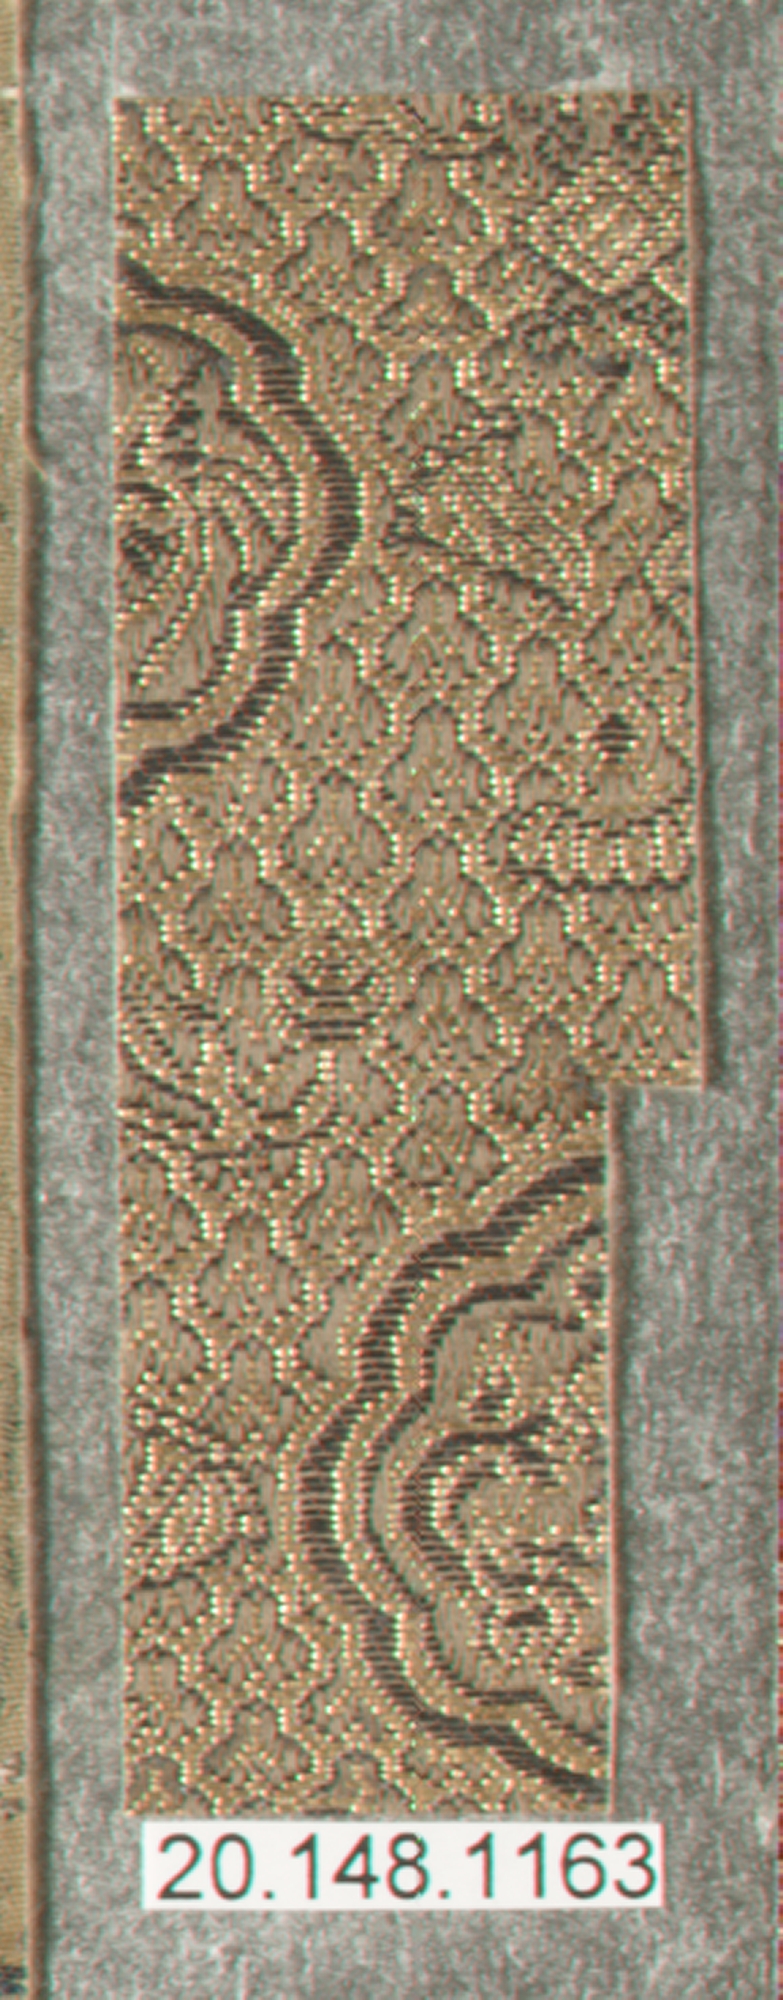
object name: piece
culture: japanese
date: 1801-1900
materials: silk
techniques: compound weave